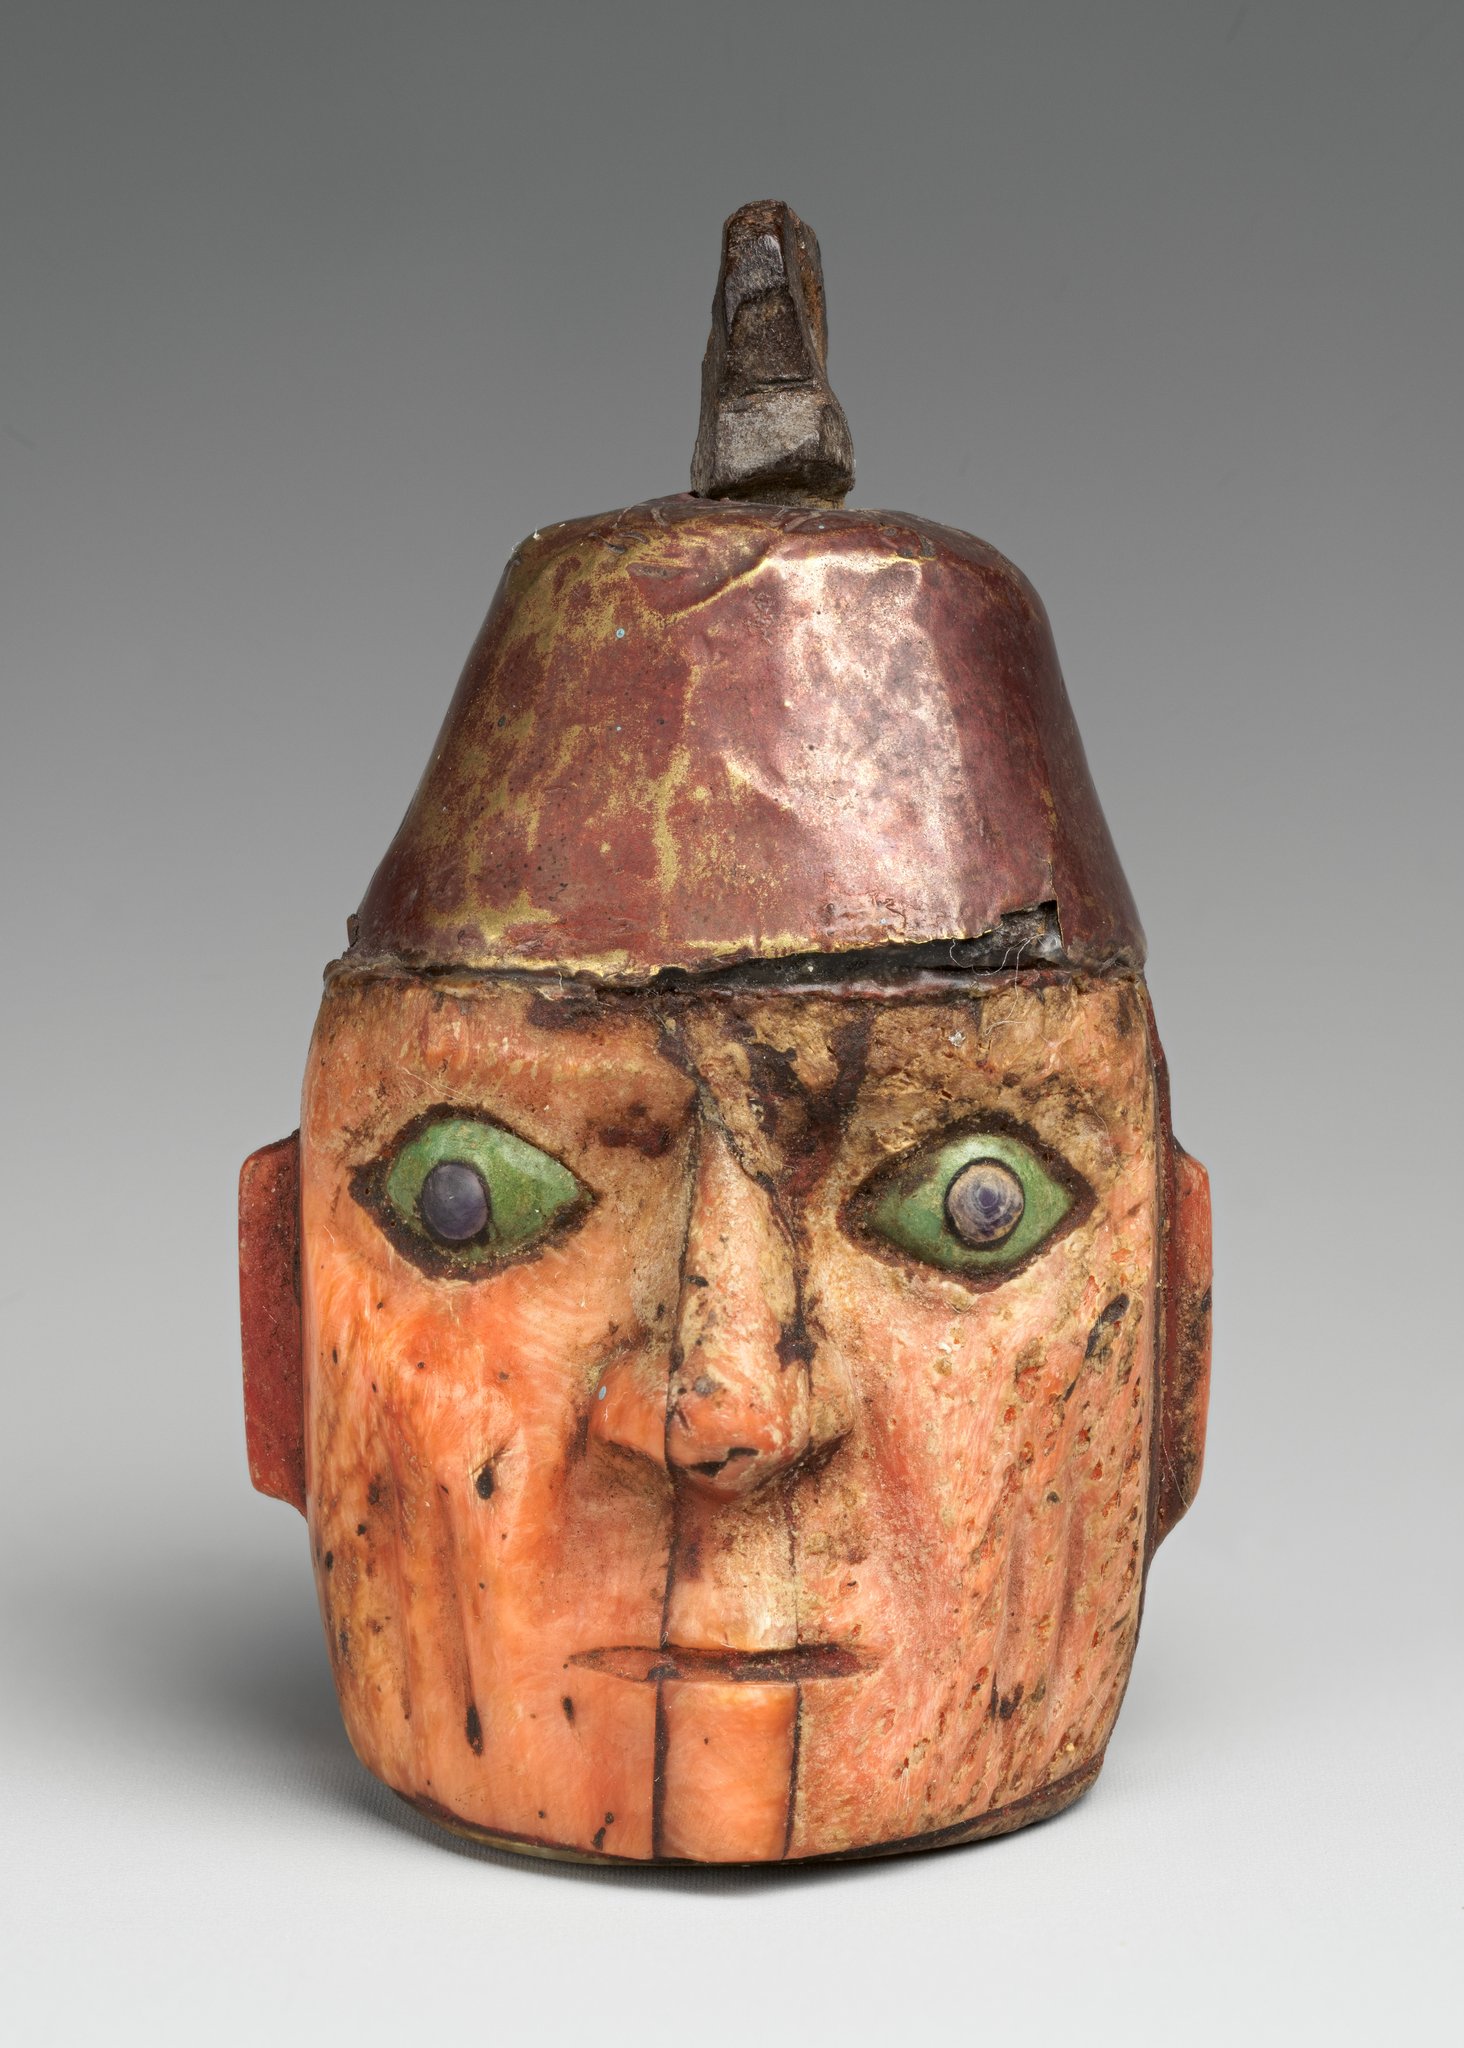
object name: lime container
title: Head Lime Container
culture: wari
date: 501-900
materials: alloy, fiber, metal, shell, stone, wood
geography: peru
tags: heads